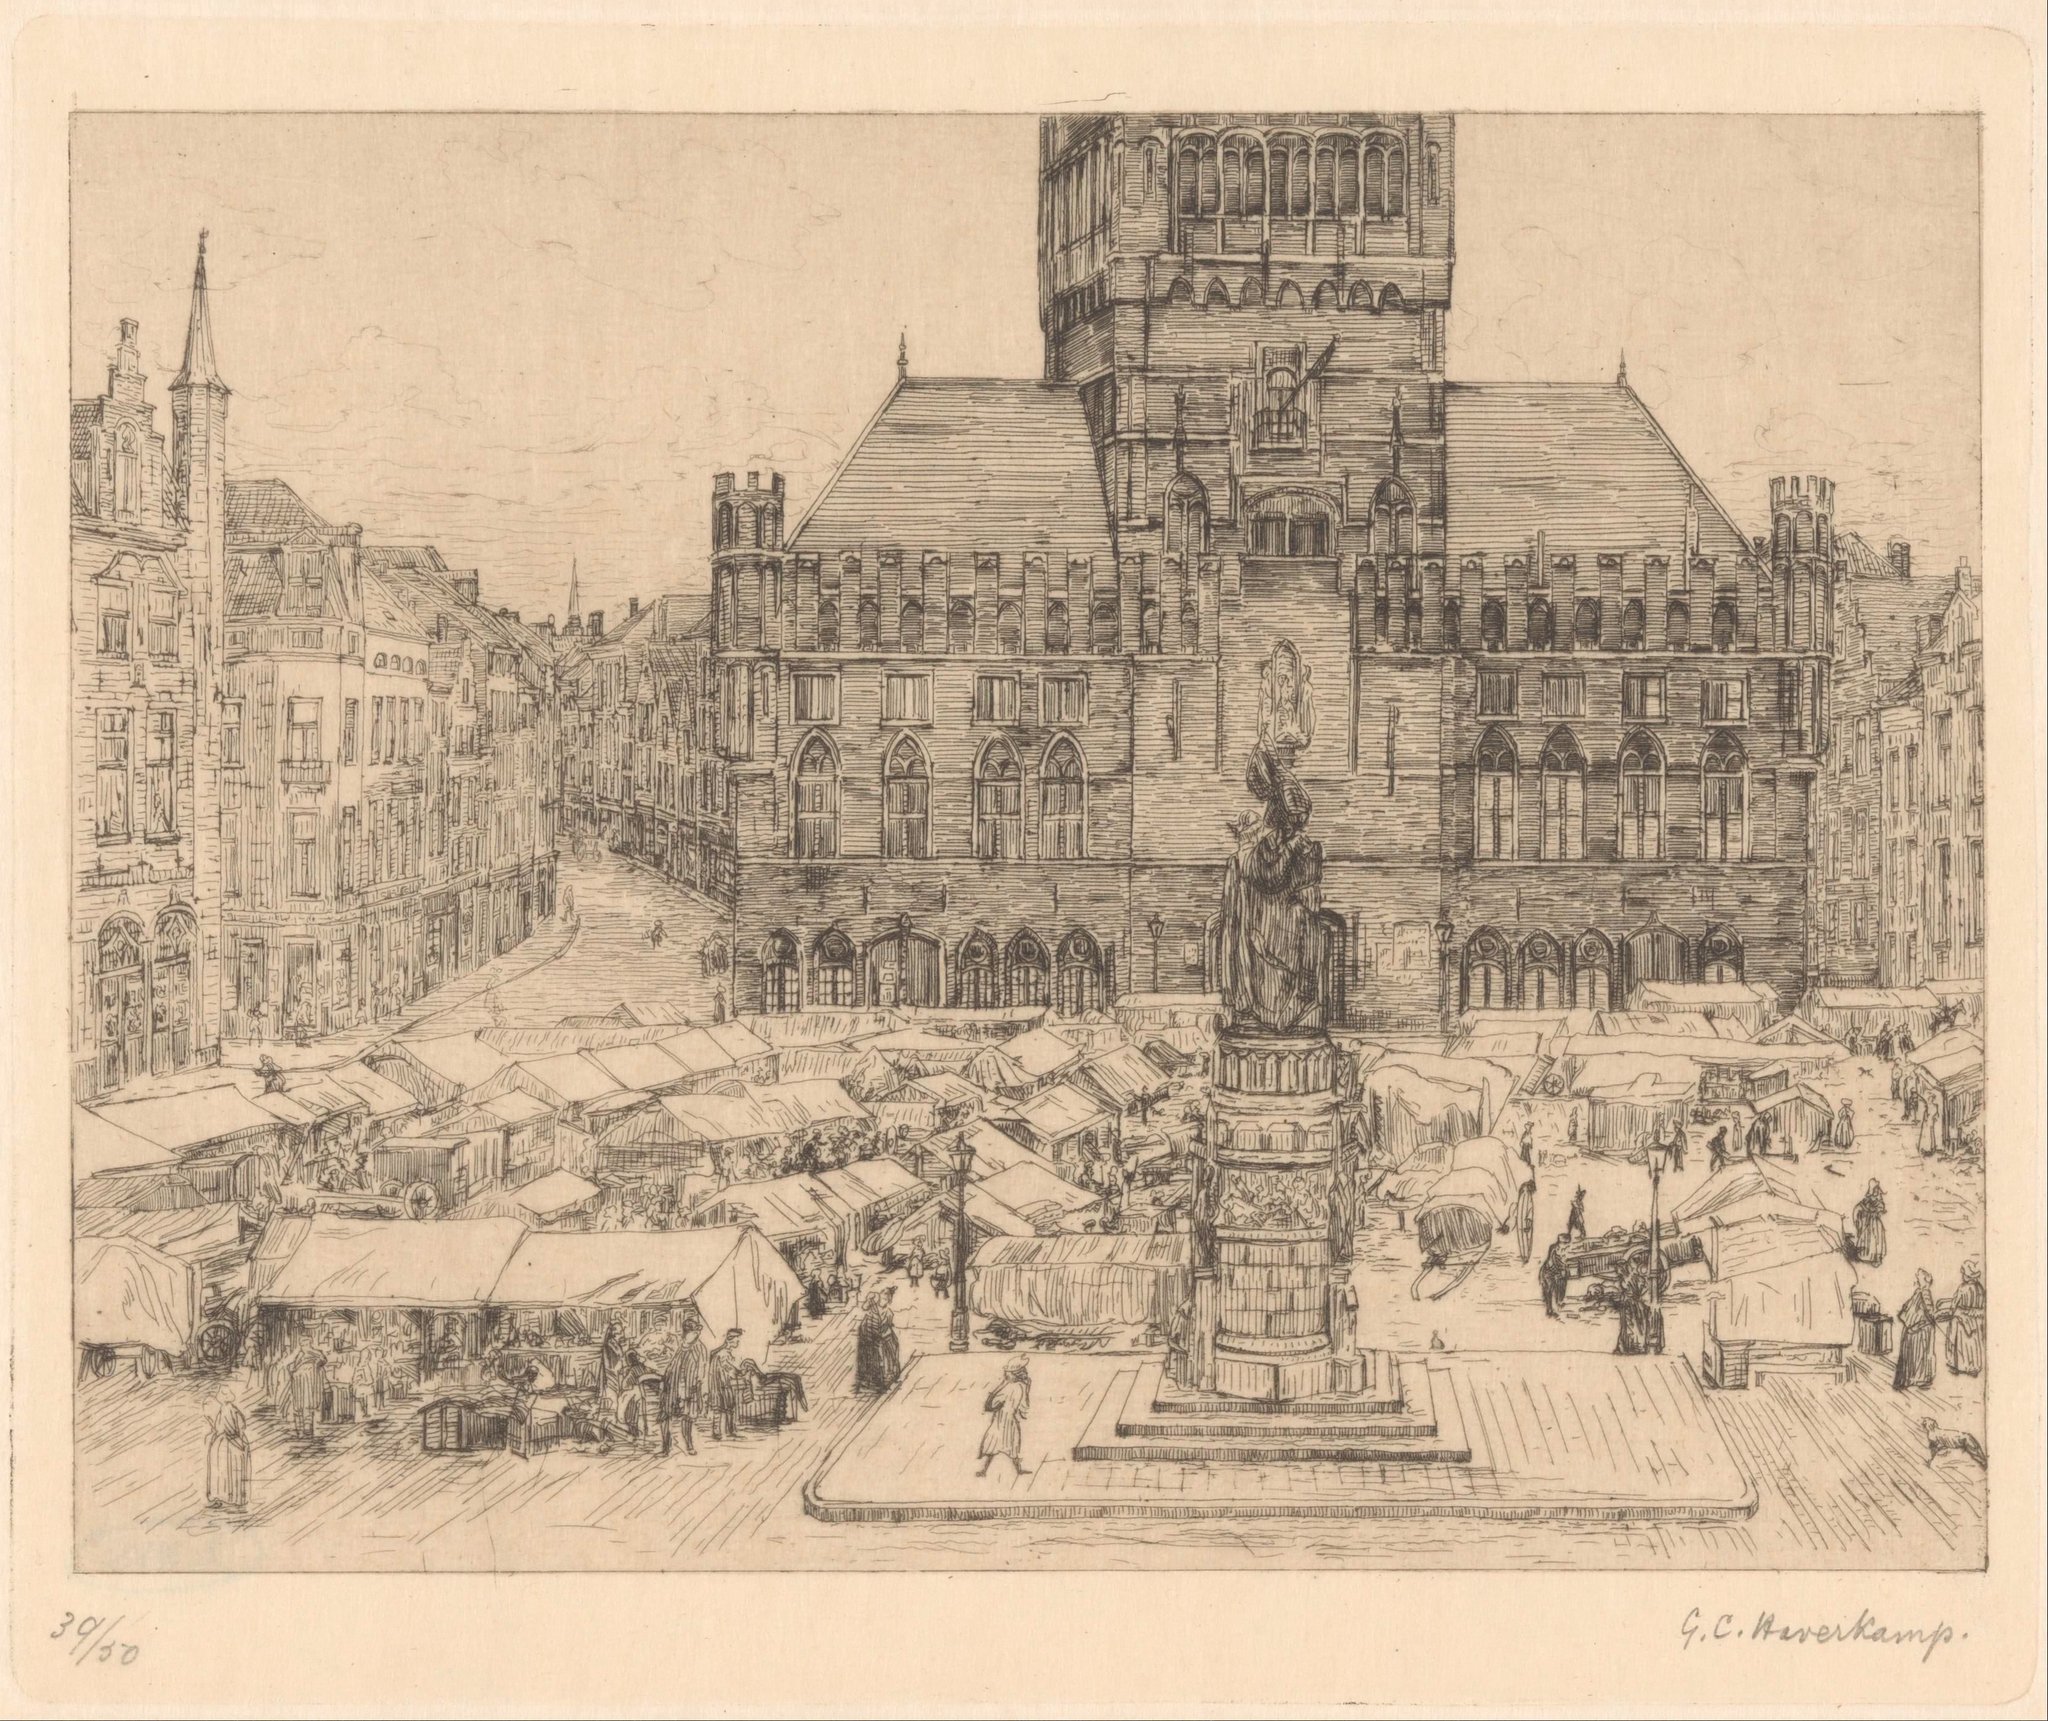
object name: print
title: Grote Markt in Brugge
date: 1882-1925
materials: paper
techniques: etching, intaglio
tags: square, place, circus, etc., monument, statue, market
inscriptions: collector's mark: Lugt 2228, collector's mark: Lugt 2760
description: De Grote Markt van Brugge met op de voorgrond het standbeeld van Jan Breydel en Pieter de Coninck. Daarachter marktkramen en het belfort.